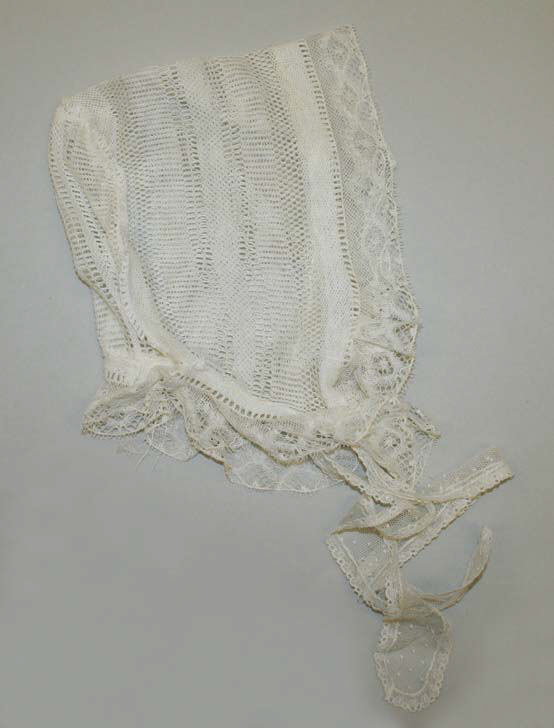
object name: cap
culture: american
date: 1800-1810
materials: cotton